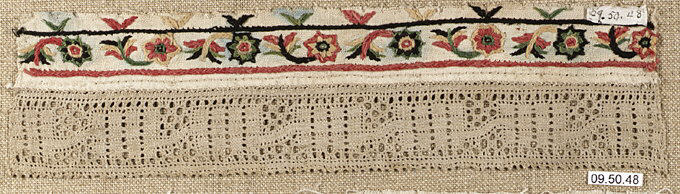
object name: strip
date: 1701-1800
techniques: lace